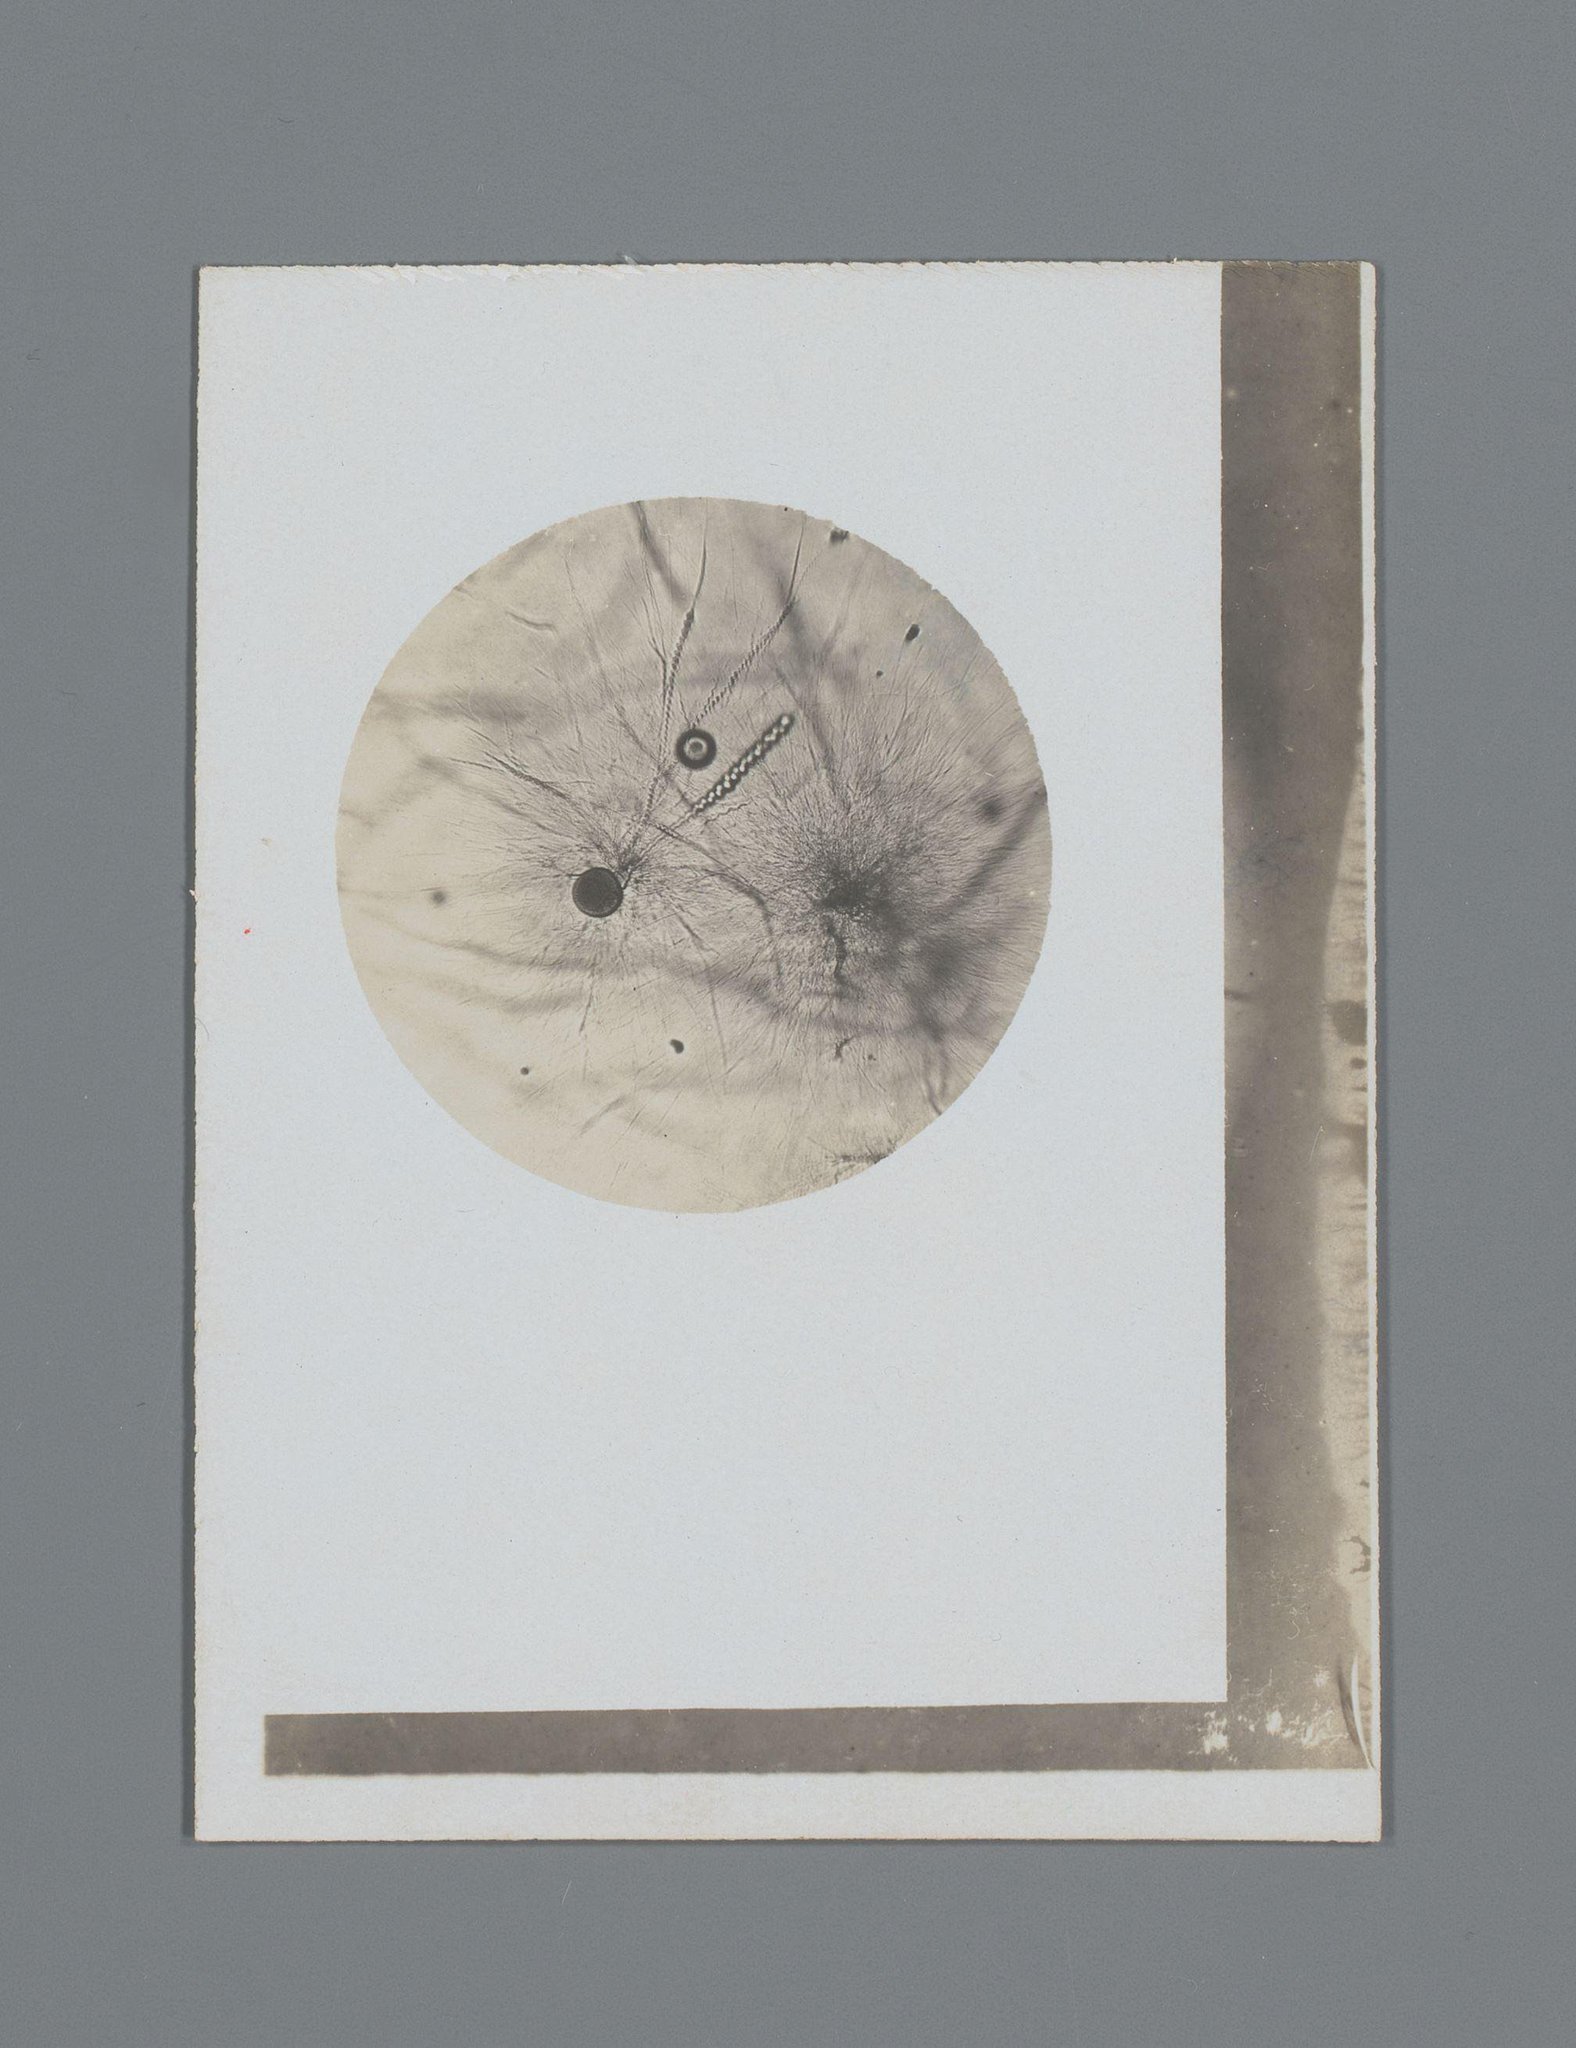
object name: photograph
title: Opname van een microscopisch preparaat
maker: Anonymous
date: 1880-1910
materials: paper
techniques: gelatin silver print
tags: unicellular animals, bacteria, bacilli